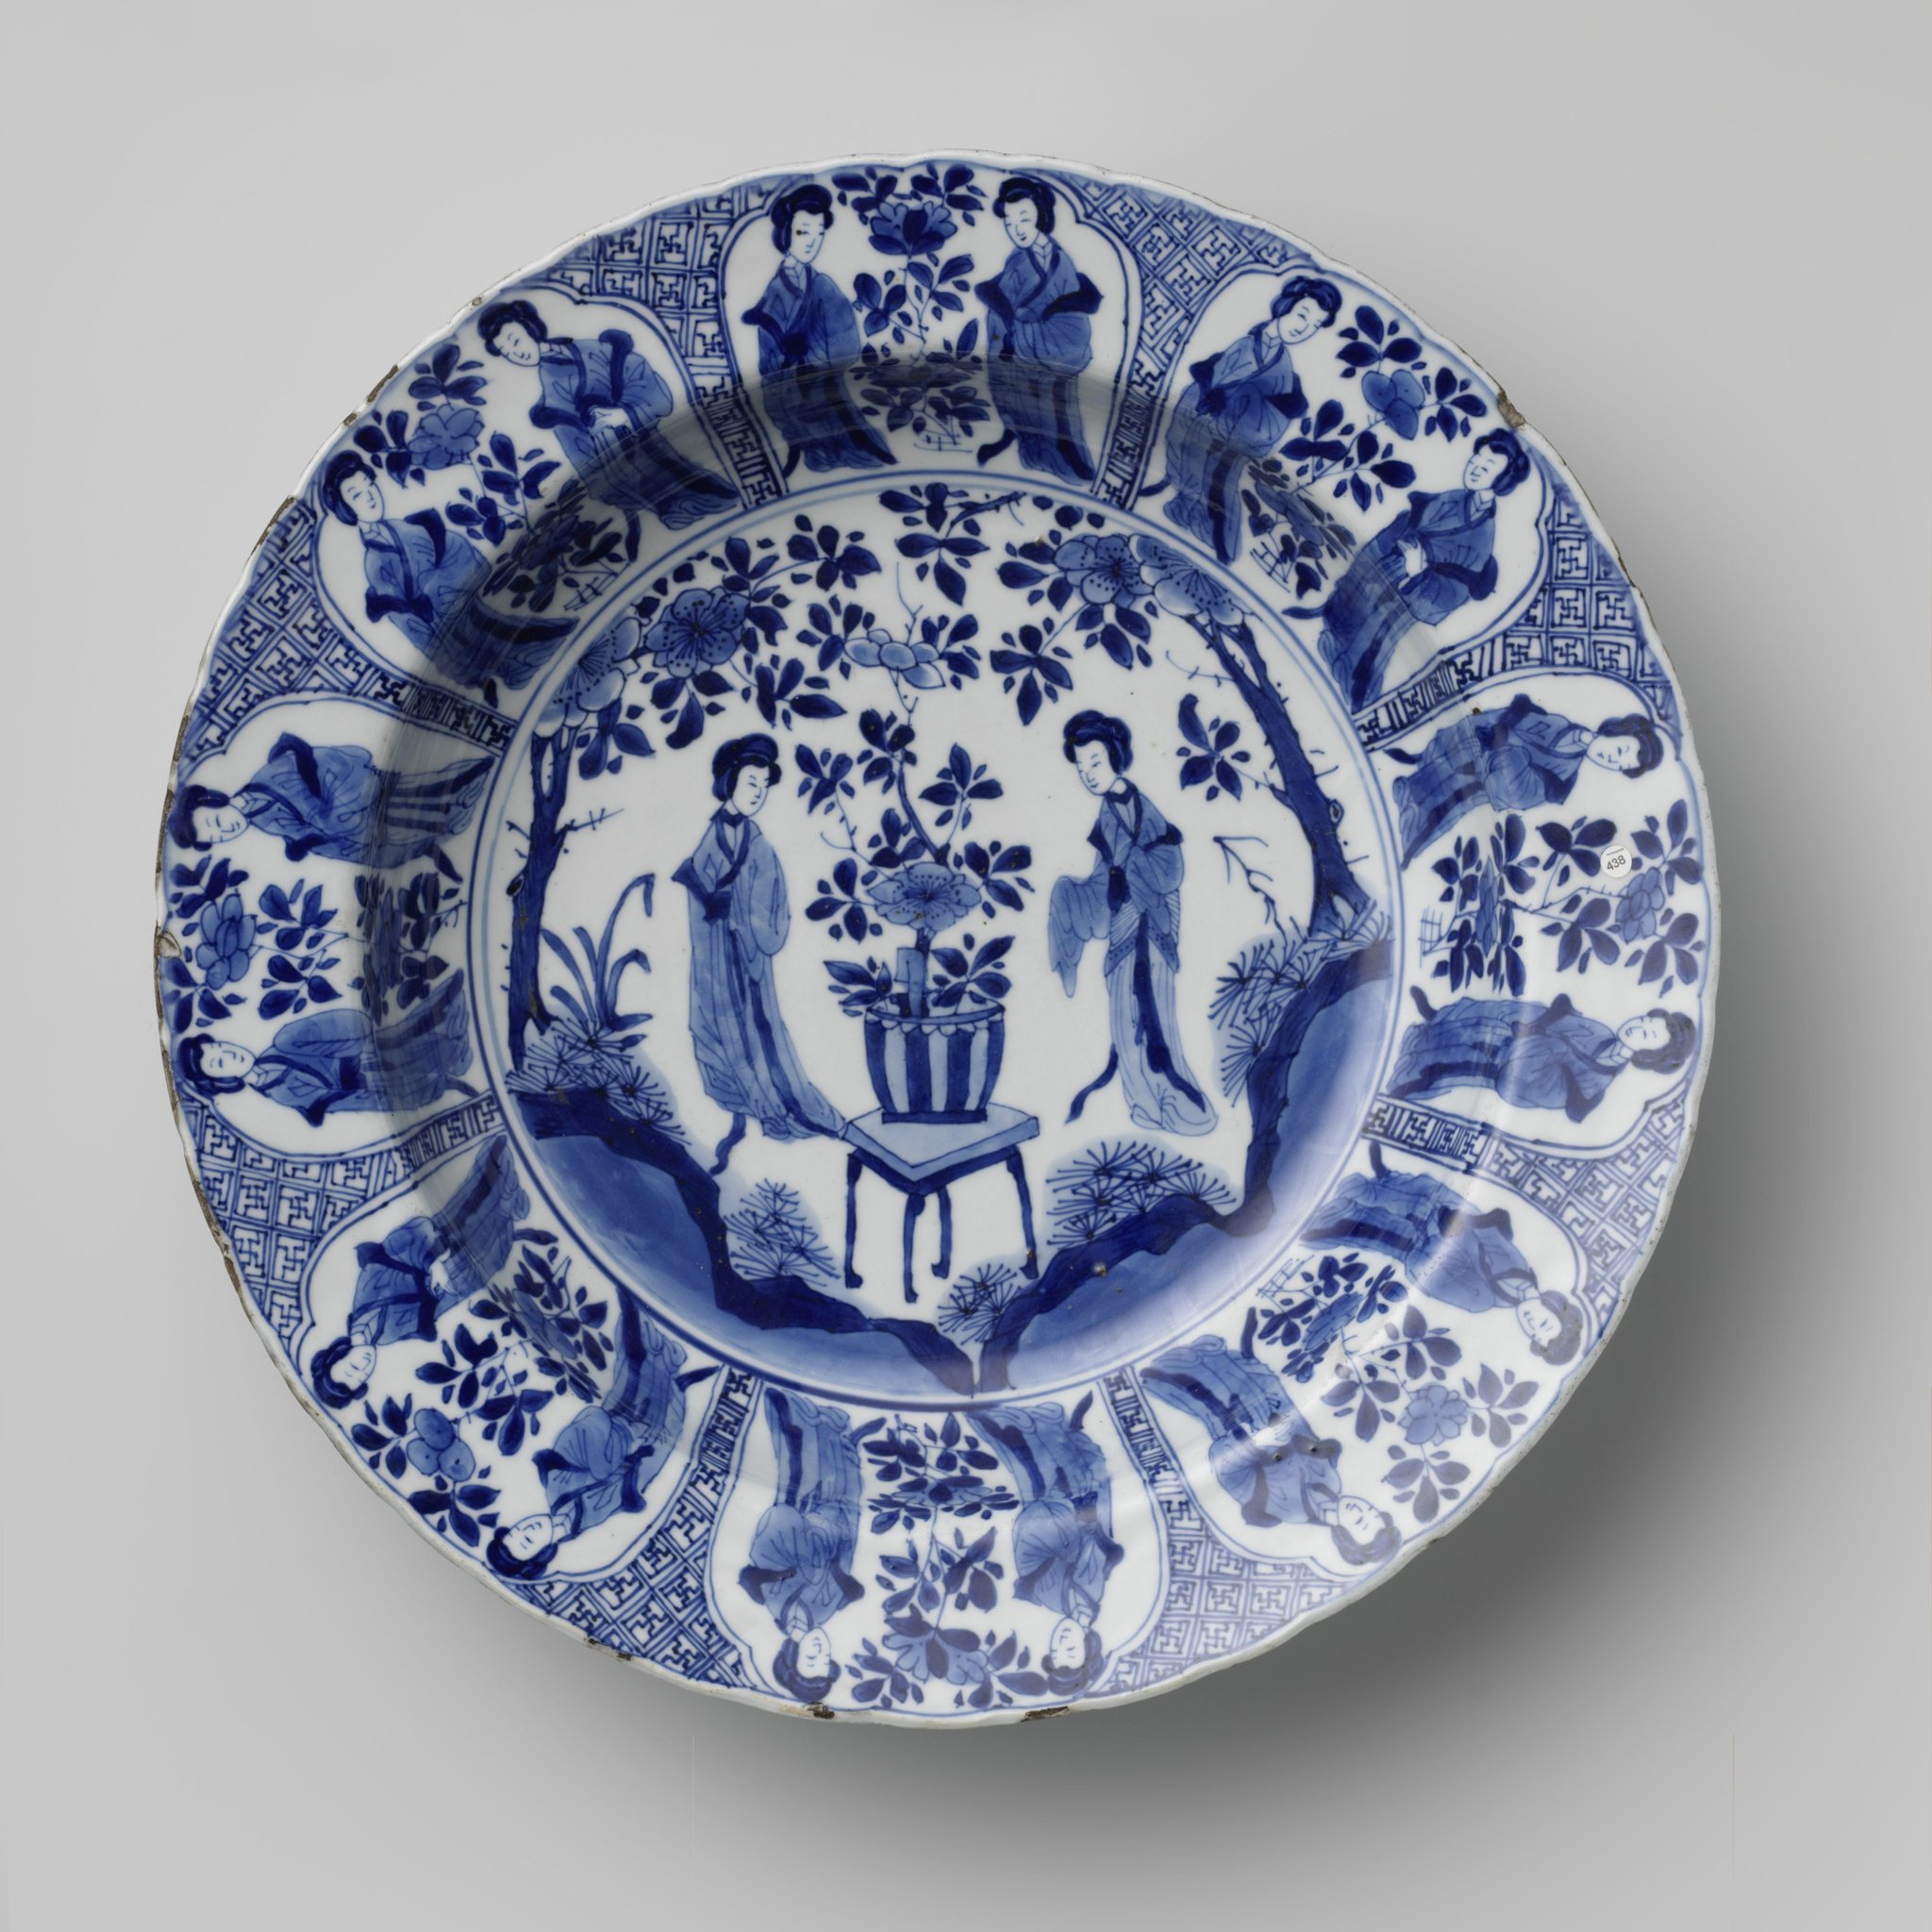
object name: platter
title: Dish with women in a garden near a flowerpot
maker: Anonymous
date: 1680-1720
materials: cobalt, glaze, paint, porcelain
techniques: firing, turning, vitrification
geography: china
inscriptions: mark: ‘大 清 康 熙 年 製’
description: Diepe schotel van porselein met een geschulpte rand, beschilderd in onderglazuur blauw. Op het plat twee vrouwen (lange lijzen) in een tuin, kijkend naar een bloempot op een lage tafel. De wand en rand zijn verdeeld in acht bloembladvormige vakken met daarin telkens twee vrouwen bij een bloeiende plant. Tussen de vakken een swastika-patroon. De buitenwand is door middel van ingegrifte lijnen verdeeld in acht vakken. Hieroverheen drie bloemtakken en een fruittak (perzik). Gemerkt op de onderzijde met het zes-karaktermerk van keizer Kangxi in een dubbele cirkel. Enkele chips in de rand. Blauw-wit.